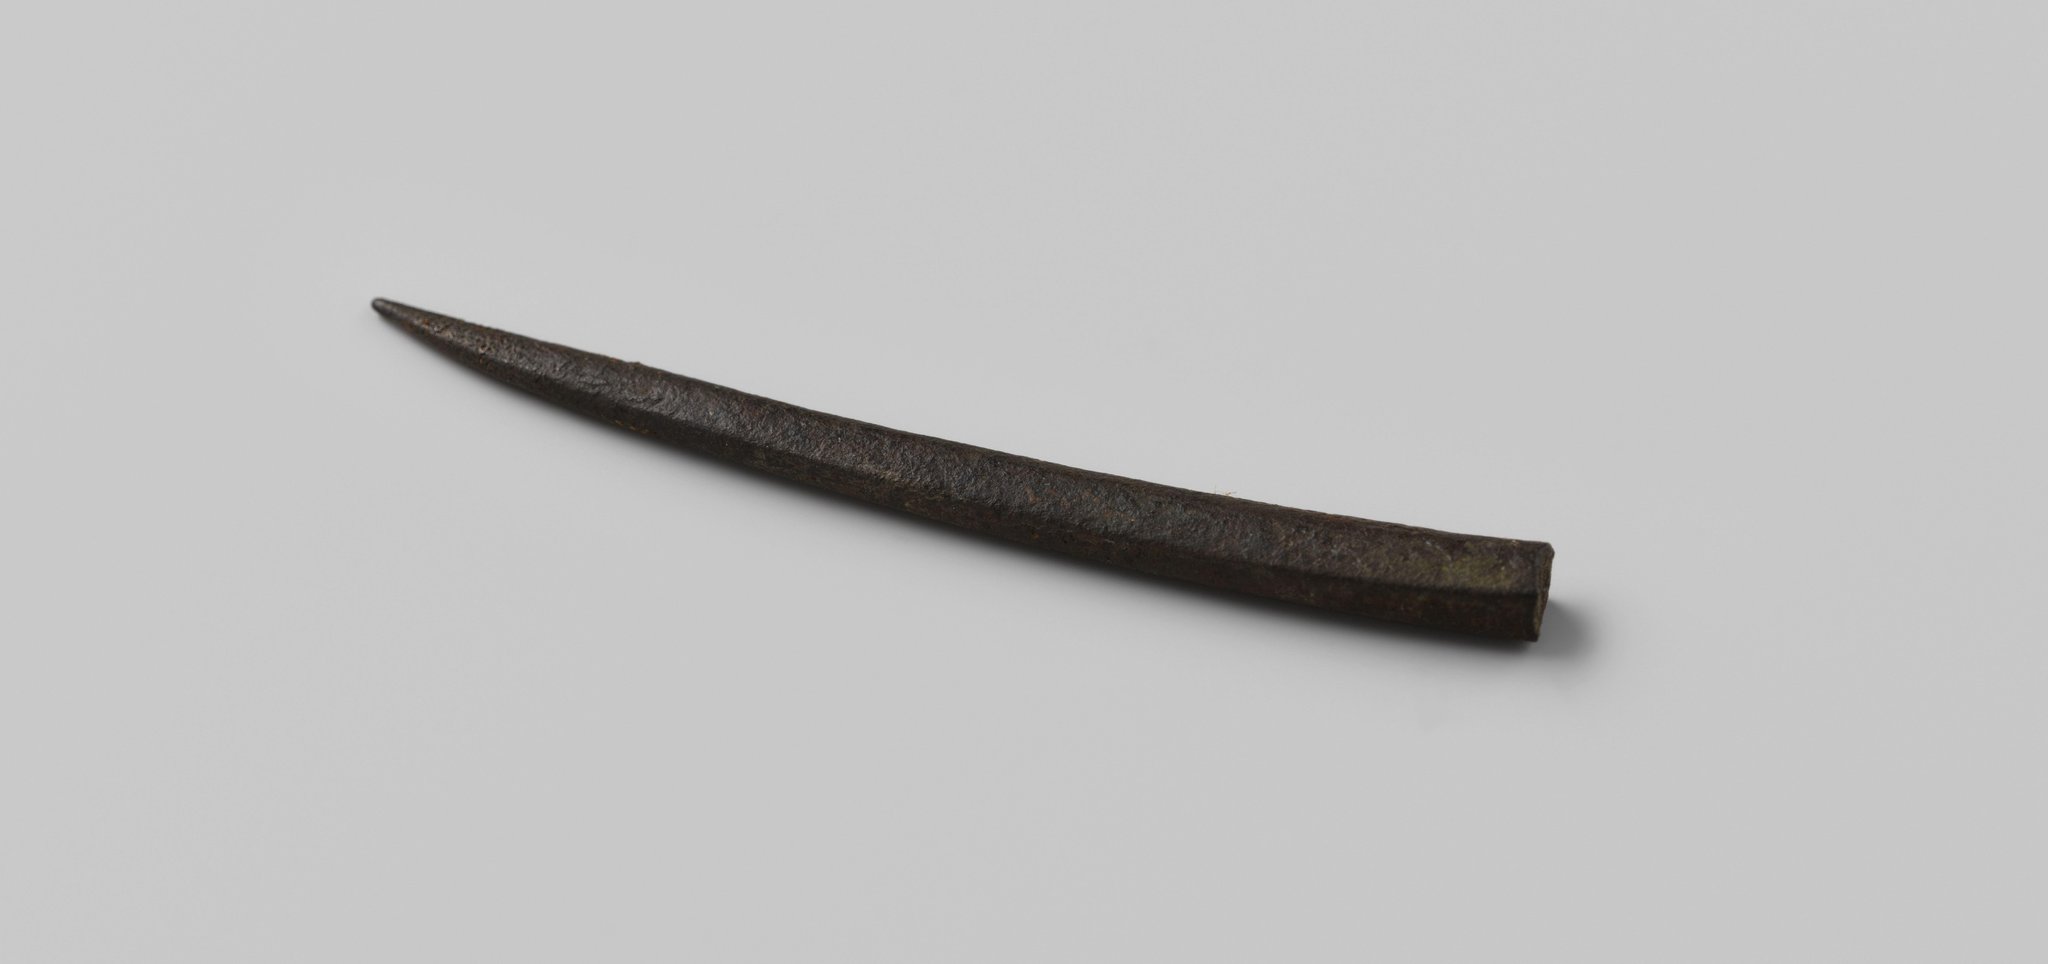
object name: fragment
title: Gepunt onderdeel uit het wrak van de Oost-Indiëvaarder Hollandia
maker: Anonymous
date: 1700-1743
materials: copper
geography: netherlands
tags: verenigde oostindische compagnie, hollandia (schip), annet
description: Varied parts or fragments, points or pointed end fragments; fragm, sim. 80H535, rectangular in section.